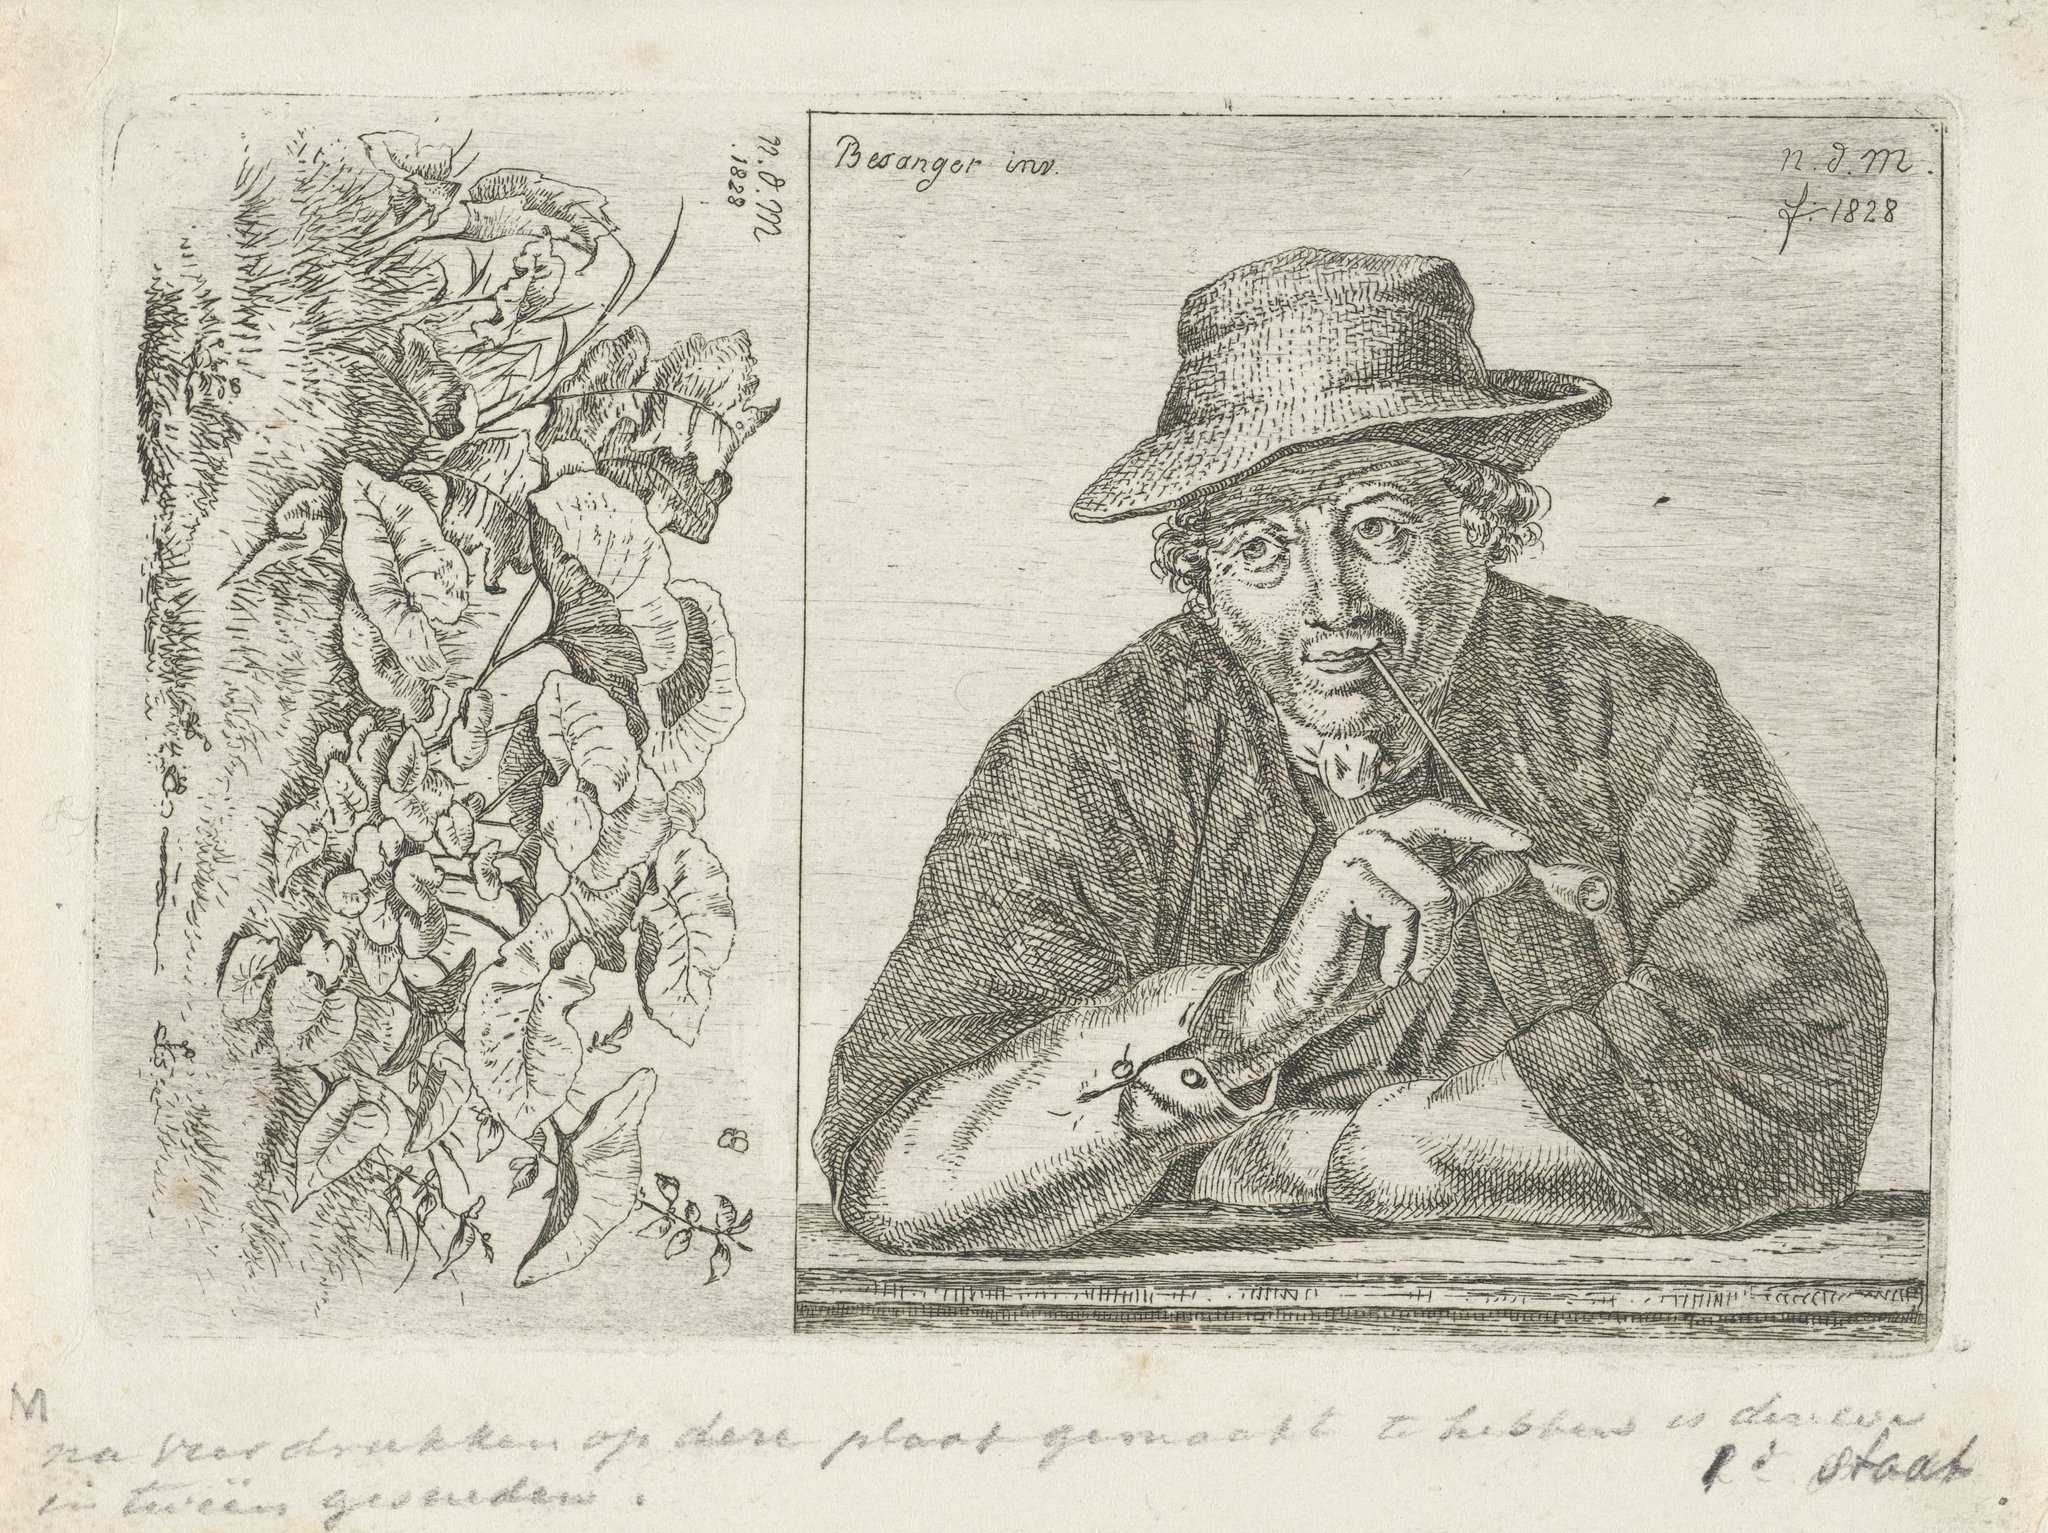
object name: print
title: Rokende man en planten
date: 1828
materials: paper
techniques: etching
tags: groups of lower plants, pipe ~ tobacco, pipe ~ tobacco (+ taking (particular) foodstuffs: eating, drinking, smoking, chewing, etc.)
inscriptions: caption: ‘Na vier drukken op deze plaat gemaakt te hebben is deze in tweeën gesneden’, collector's mark: Lugt 2228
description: Twee afbeeldingen op een afdruk: Rechts een rokende man, met zijn armen leunend op een richel voor hem. Links planten, de afbeelding op zijn kant afgebeeld.